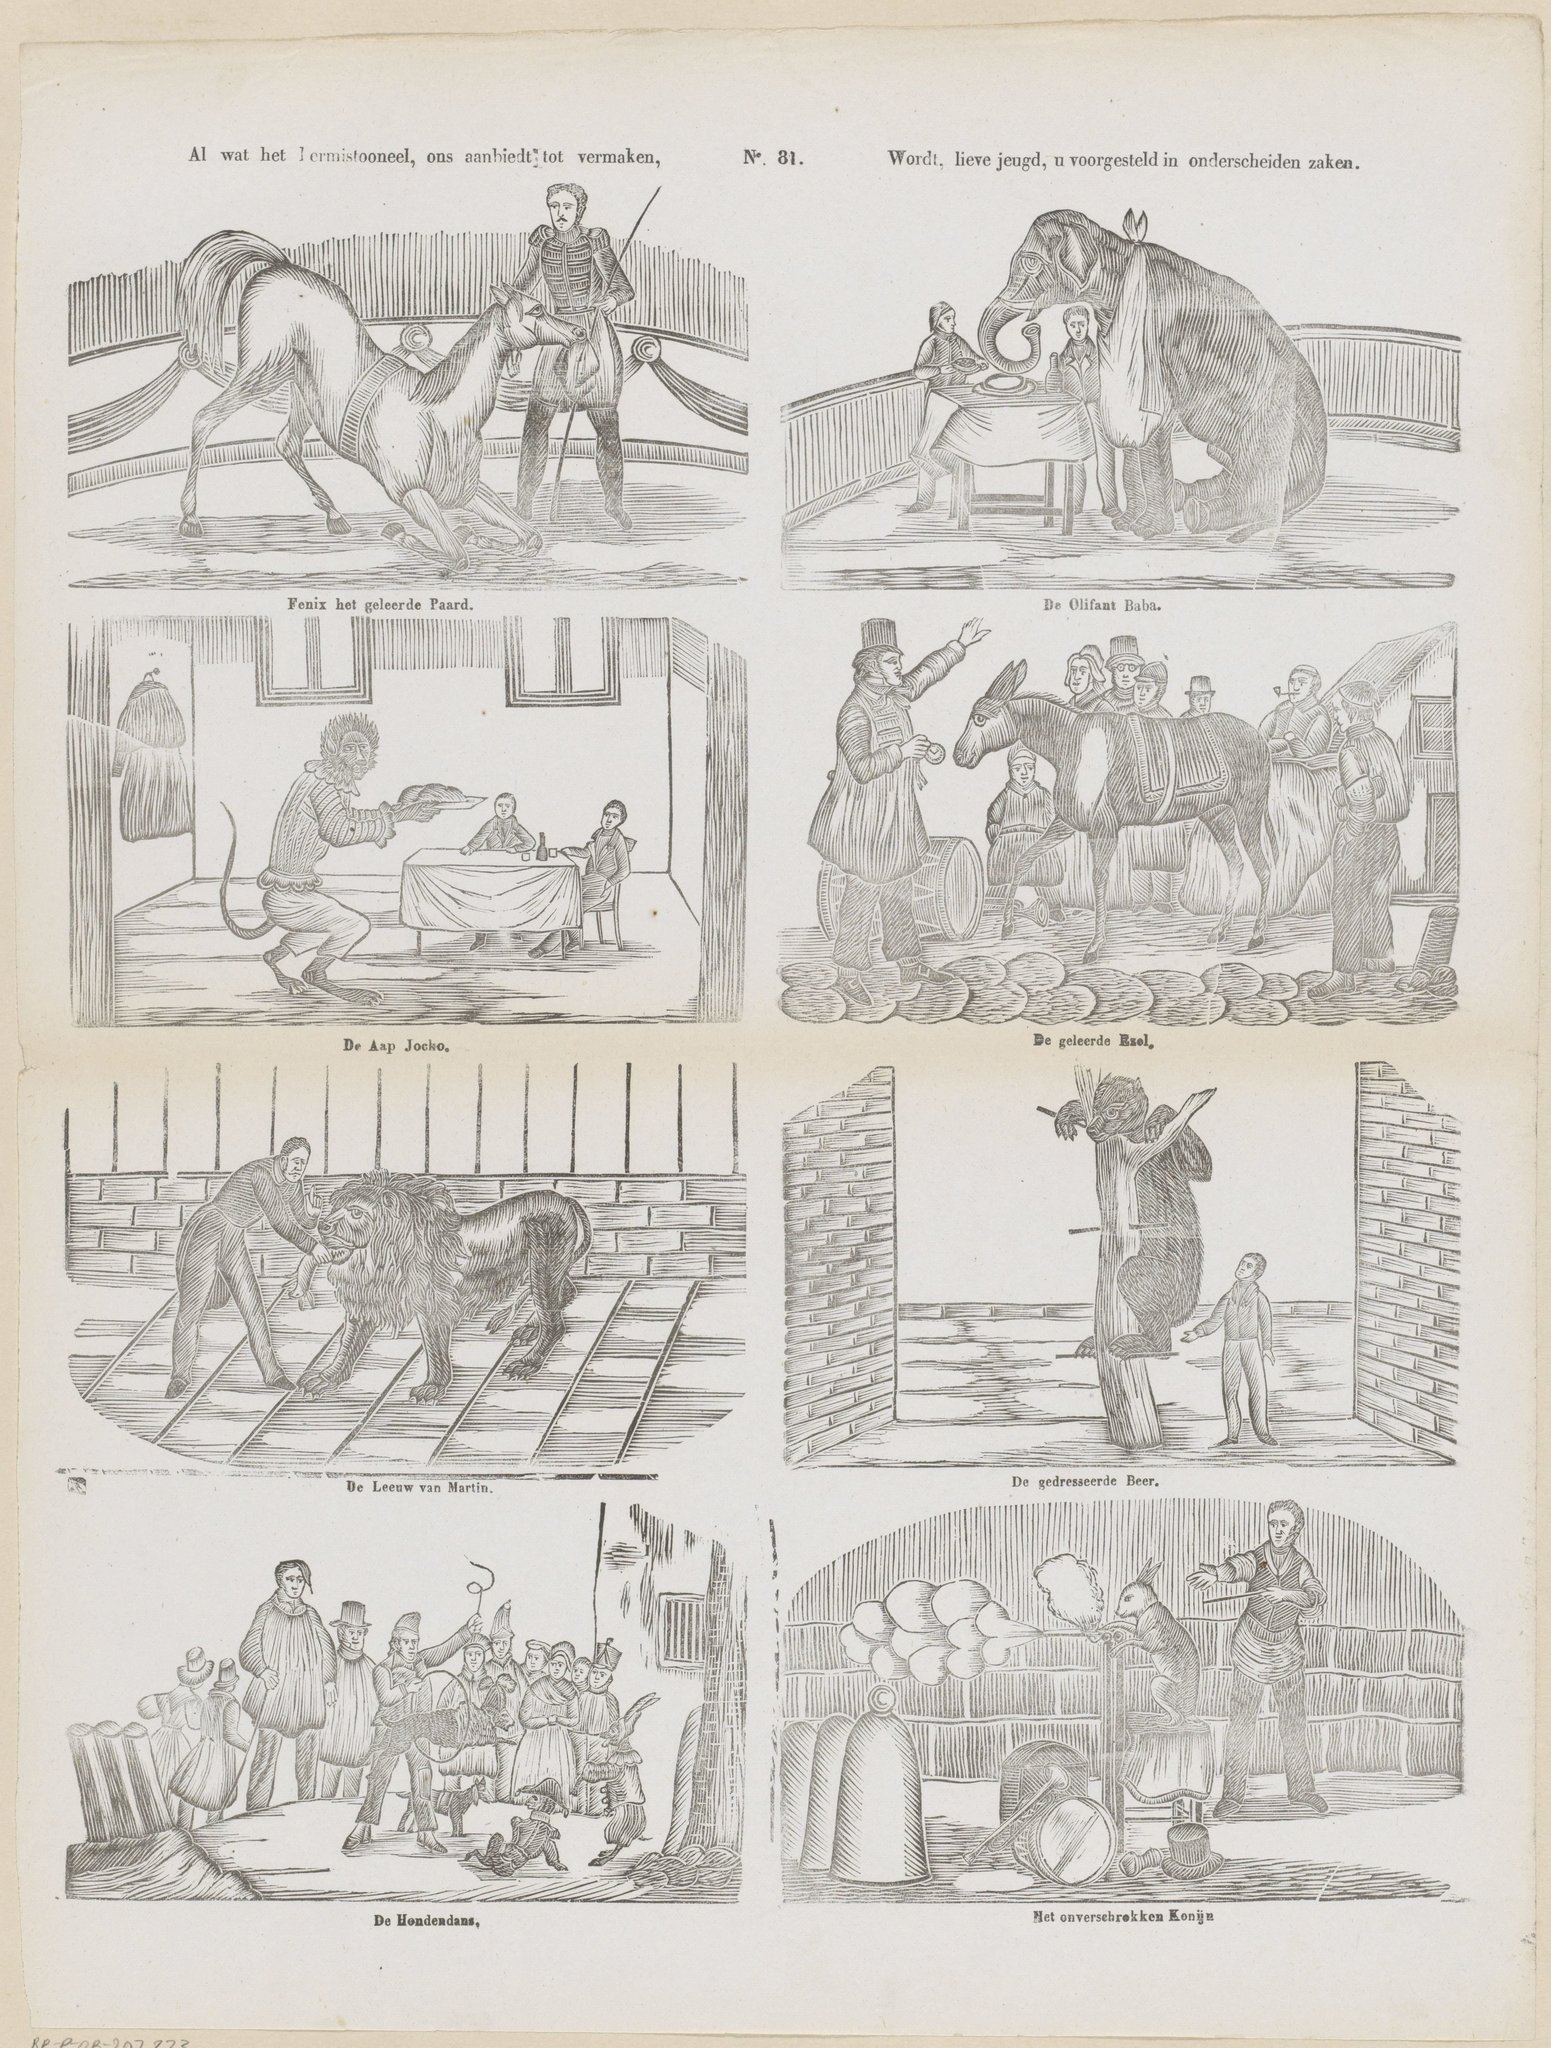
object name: print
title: Al wat het kermistooneel, ons aanbiedt tot vermaken, / Wordt lieve jeugd, u voorgesteld in onderscheiden zaken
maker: Anonymous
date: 1848-1881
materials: paper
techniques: letterpress printing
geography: netherlands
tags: circus animals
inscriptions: collector's mark: Lugt 2760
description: Blad met 8 voorstellingen van circusdieren. Onder elke afbeelding een onderschrift. Genummerd midden boven: No. 81.